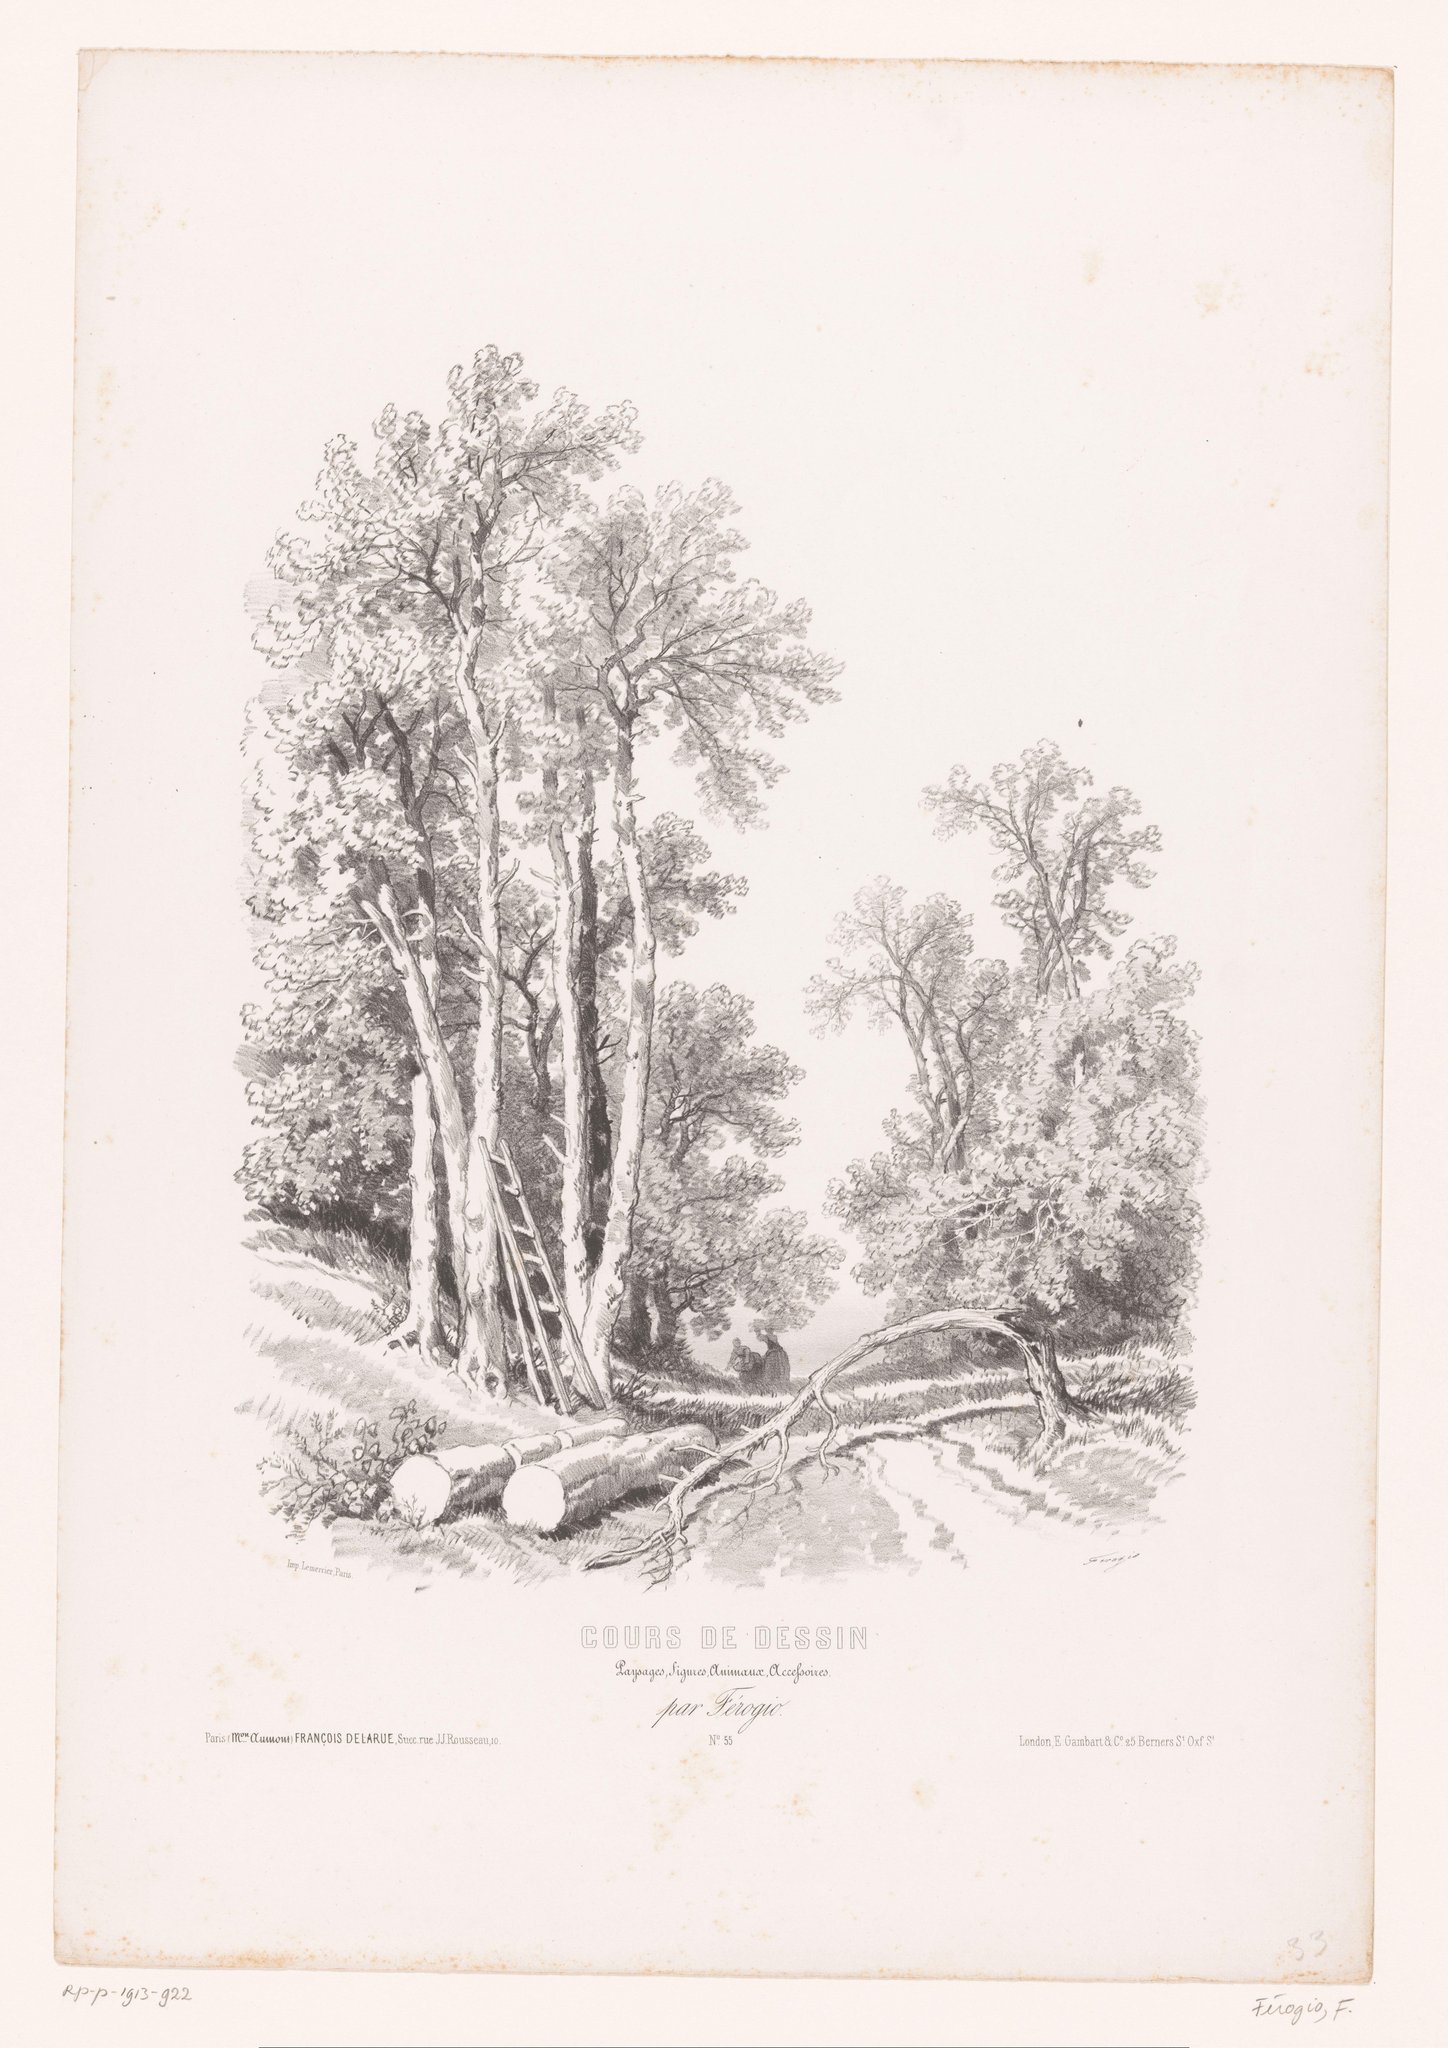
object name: print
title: Bosgezicht met twee hout sprokkelende vrouwen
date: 1845-1846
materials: paper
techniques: lithograph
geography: paris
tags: forest, wood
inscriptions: collector's mark: Lugt 2228a